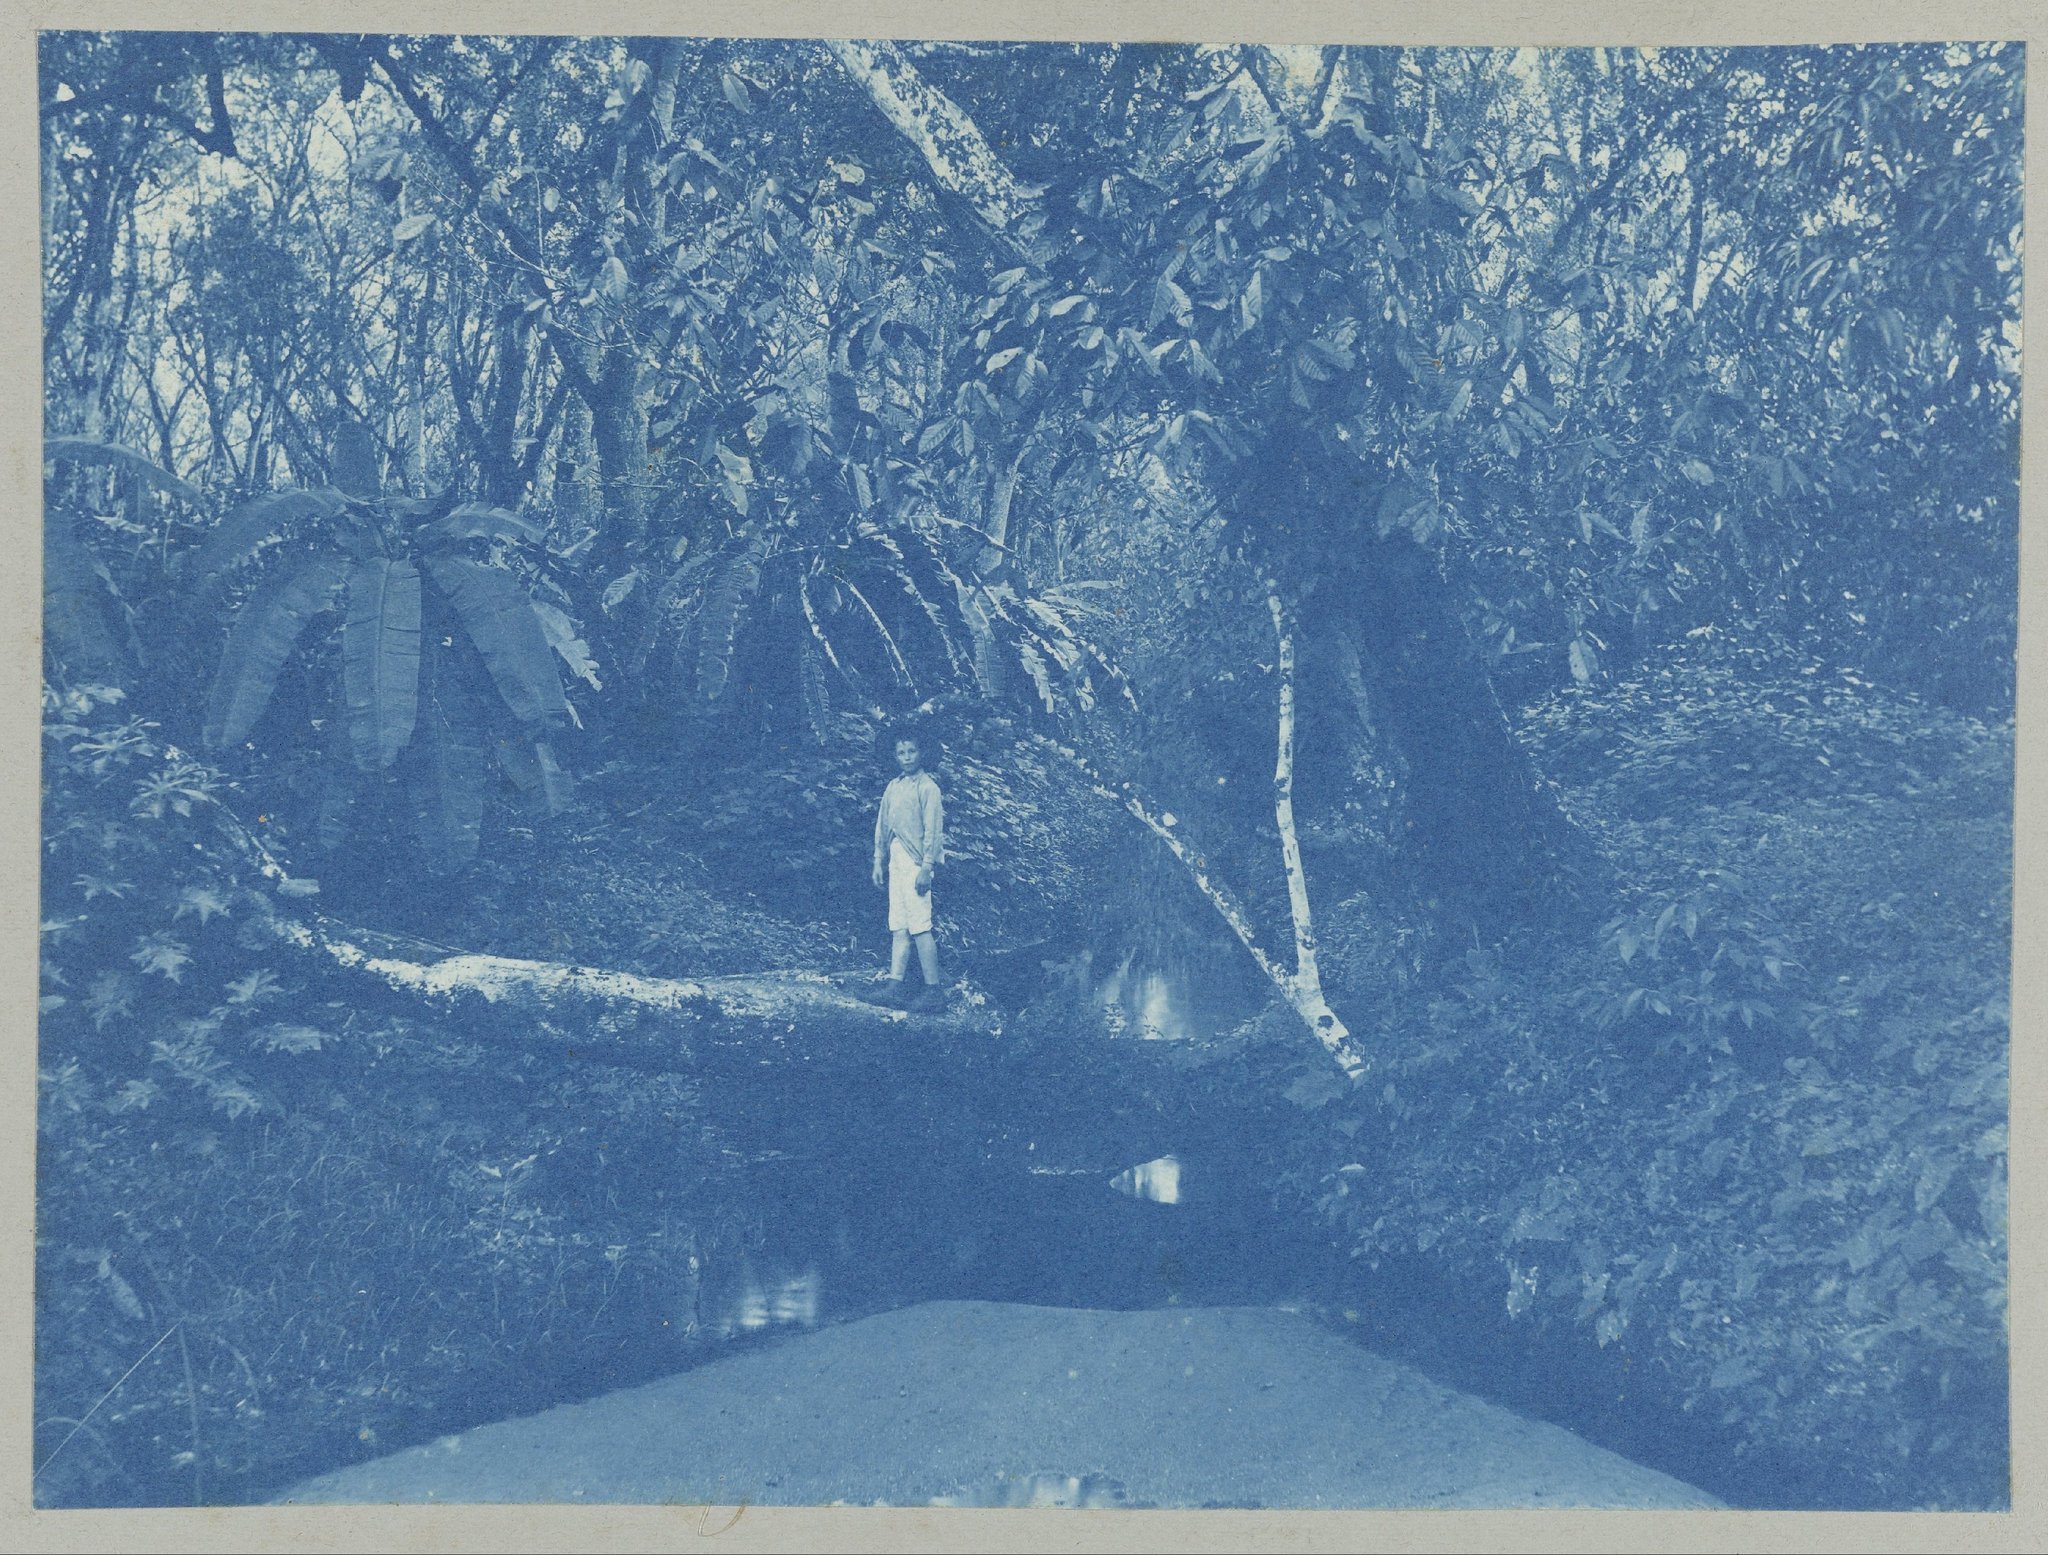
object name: photograph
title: Anton bij sluis in achterdam van "Ma retraite"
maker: hendrik doijer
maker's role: engineer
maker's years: 1863-1925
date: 1903-1910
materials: photographic support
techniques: cyanotype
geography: suriname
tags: suriname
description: De Nederlandse jongen Anton staande op een boom bij de sluis op het terrein van de plantage Ma Retraite. Onderdeel van het fotoalbum Souvenir de Voyage (deel 1), over het leven van de familie Doijer in en rond de plantage Ma Retraite in Suriname in de jaren 1903-1910.